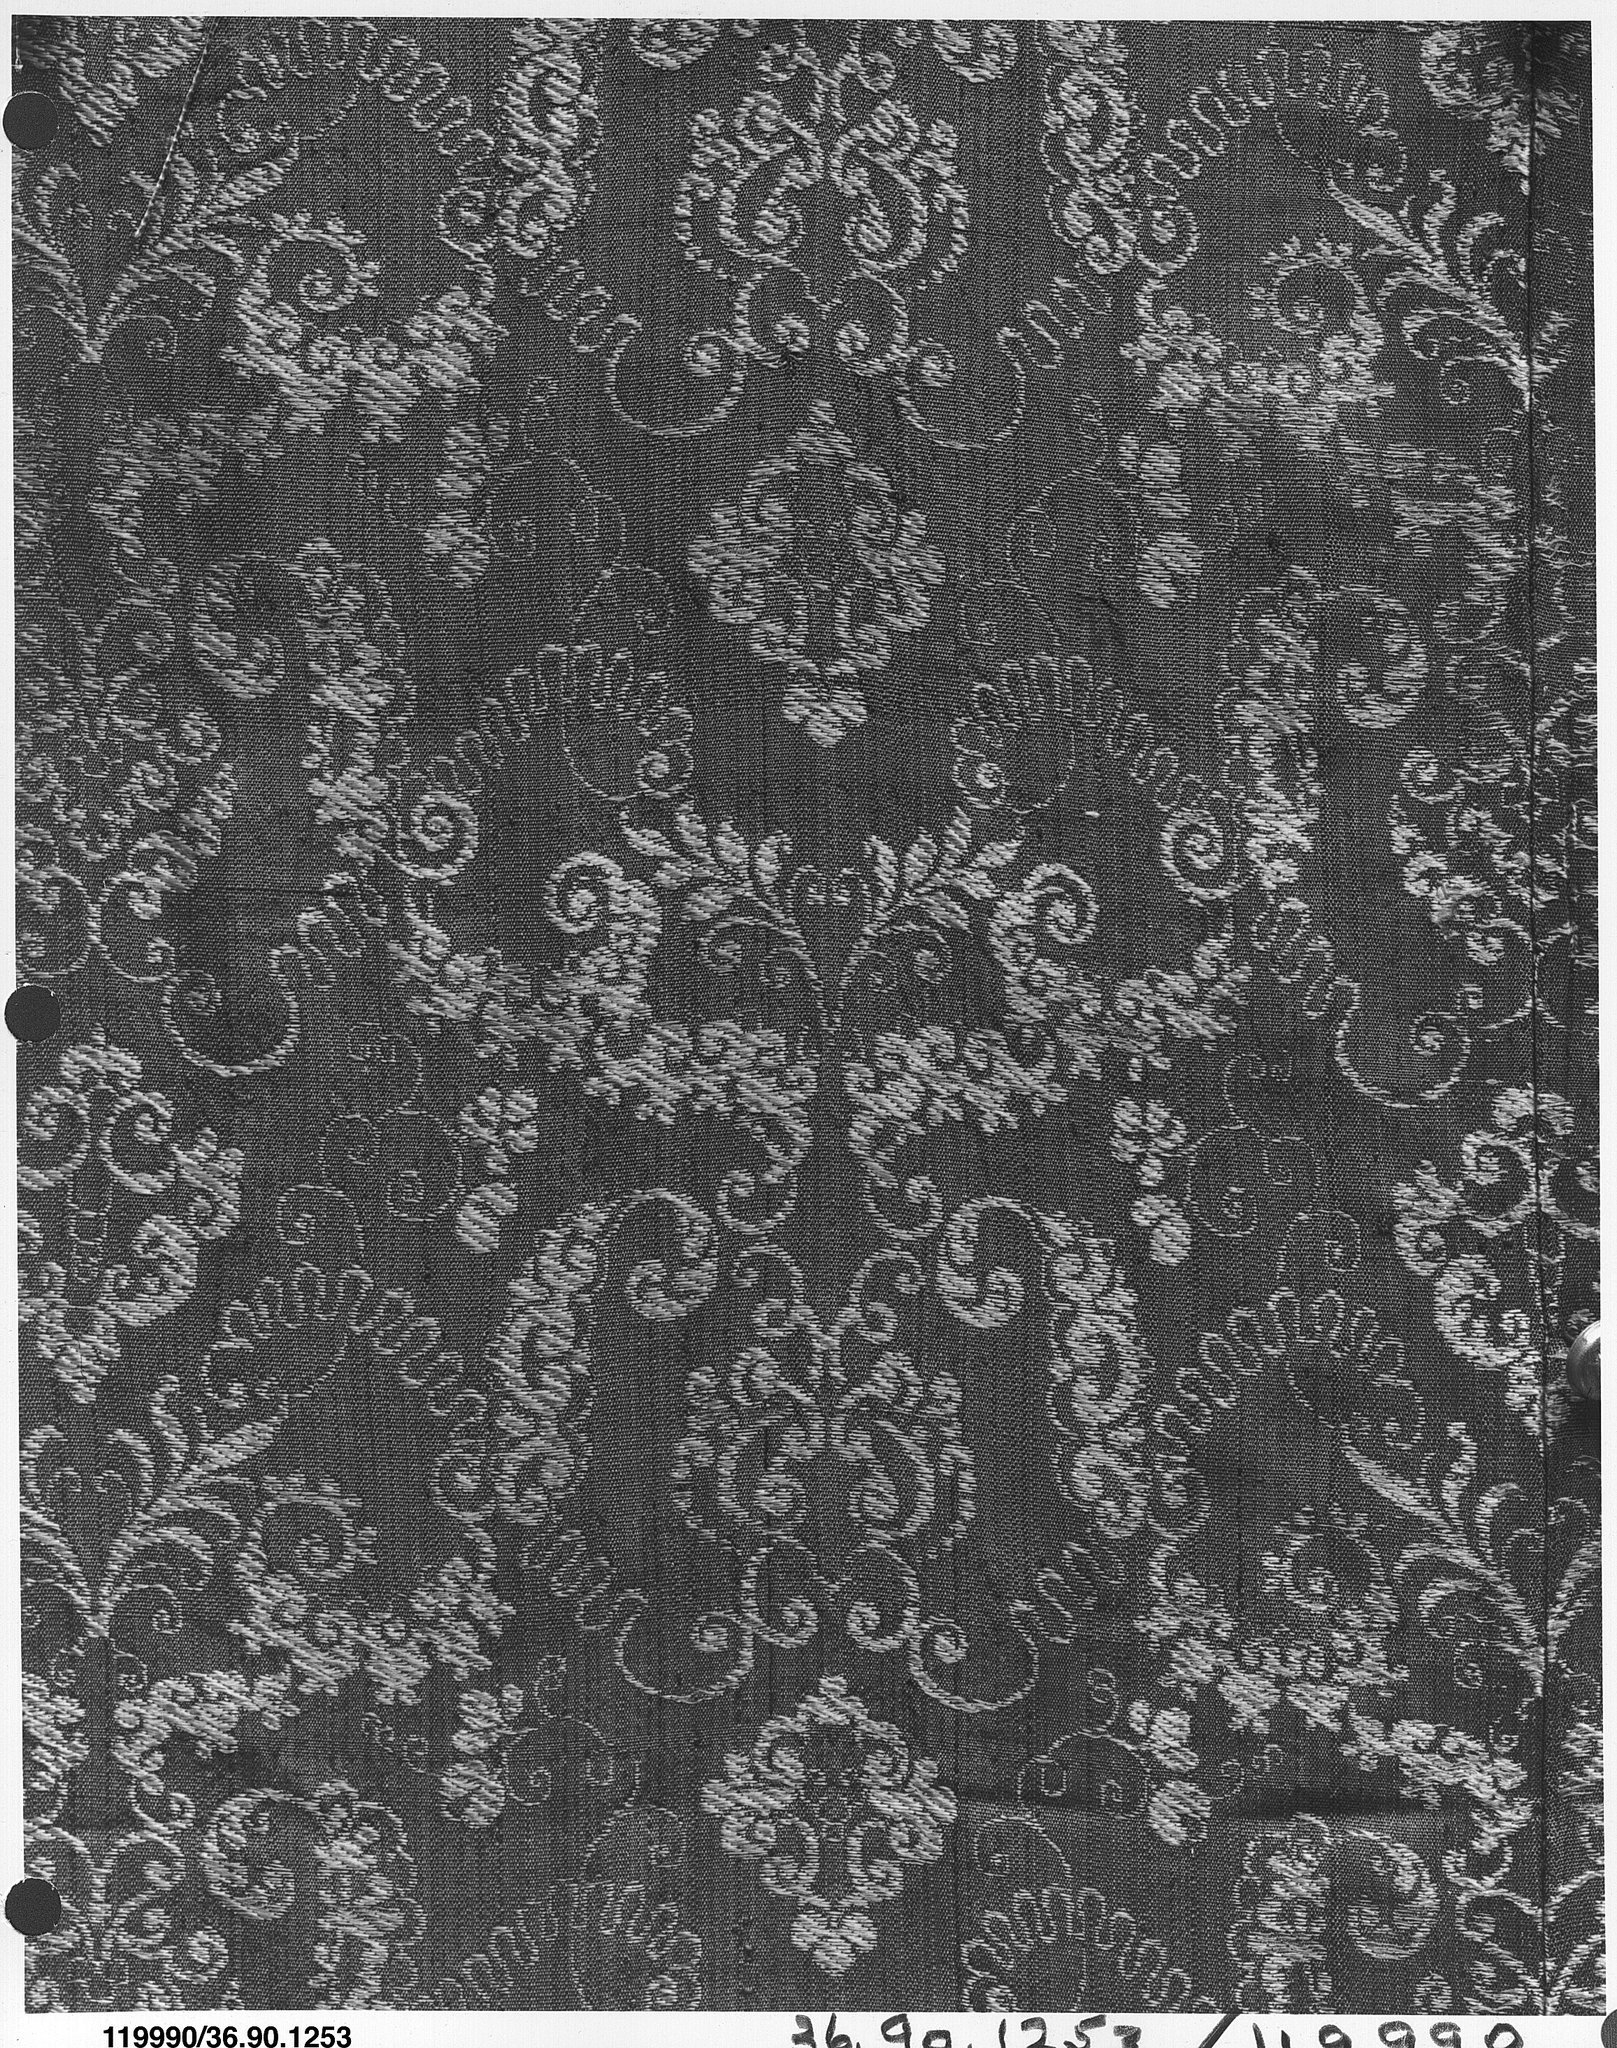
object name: piece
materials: silk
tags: flowers,leaves